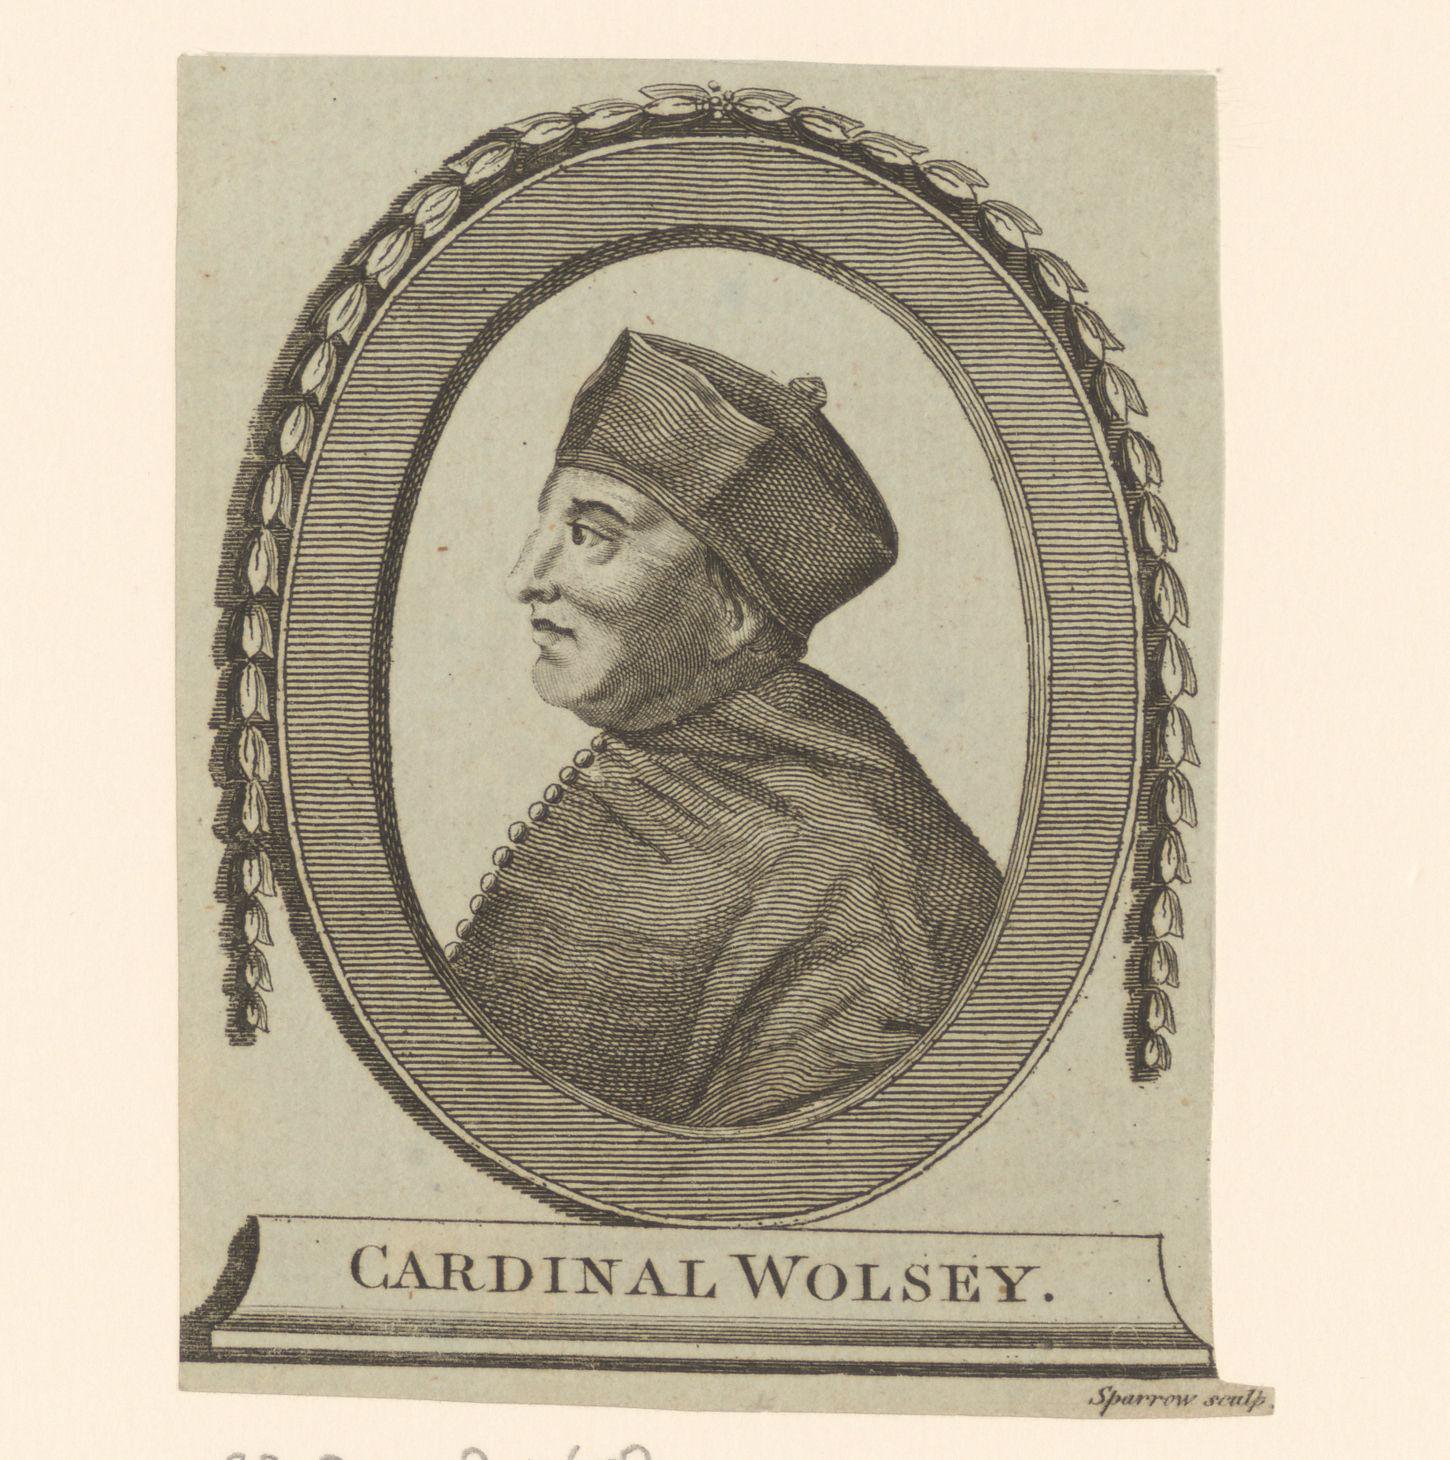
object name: print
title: Cardinal Wolsey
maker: sparrow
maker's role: print maker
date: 1770-1800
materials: paper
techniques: etching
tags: cardinal, historical persons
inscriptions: collector's mark: Lugt 2228